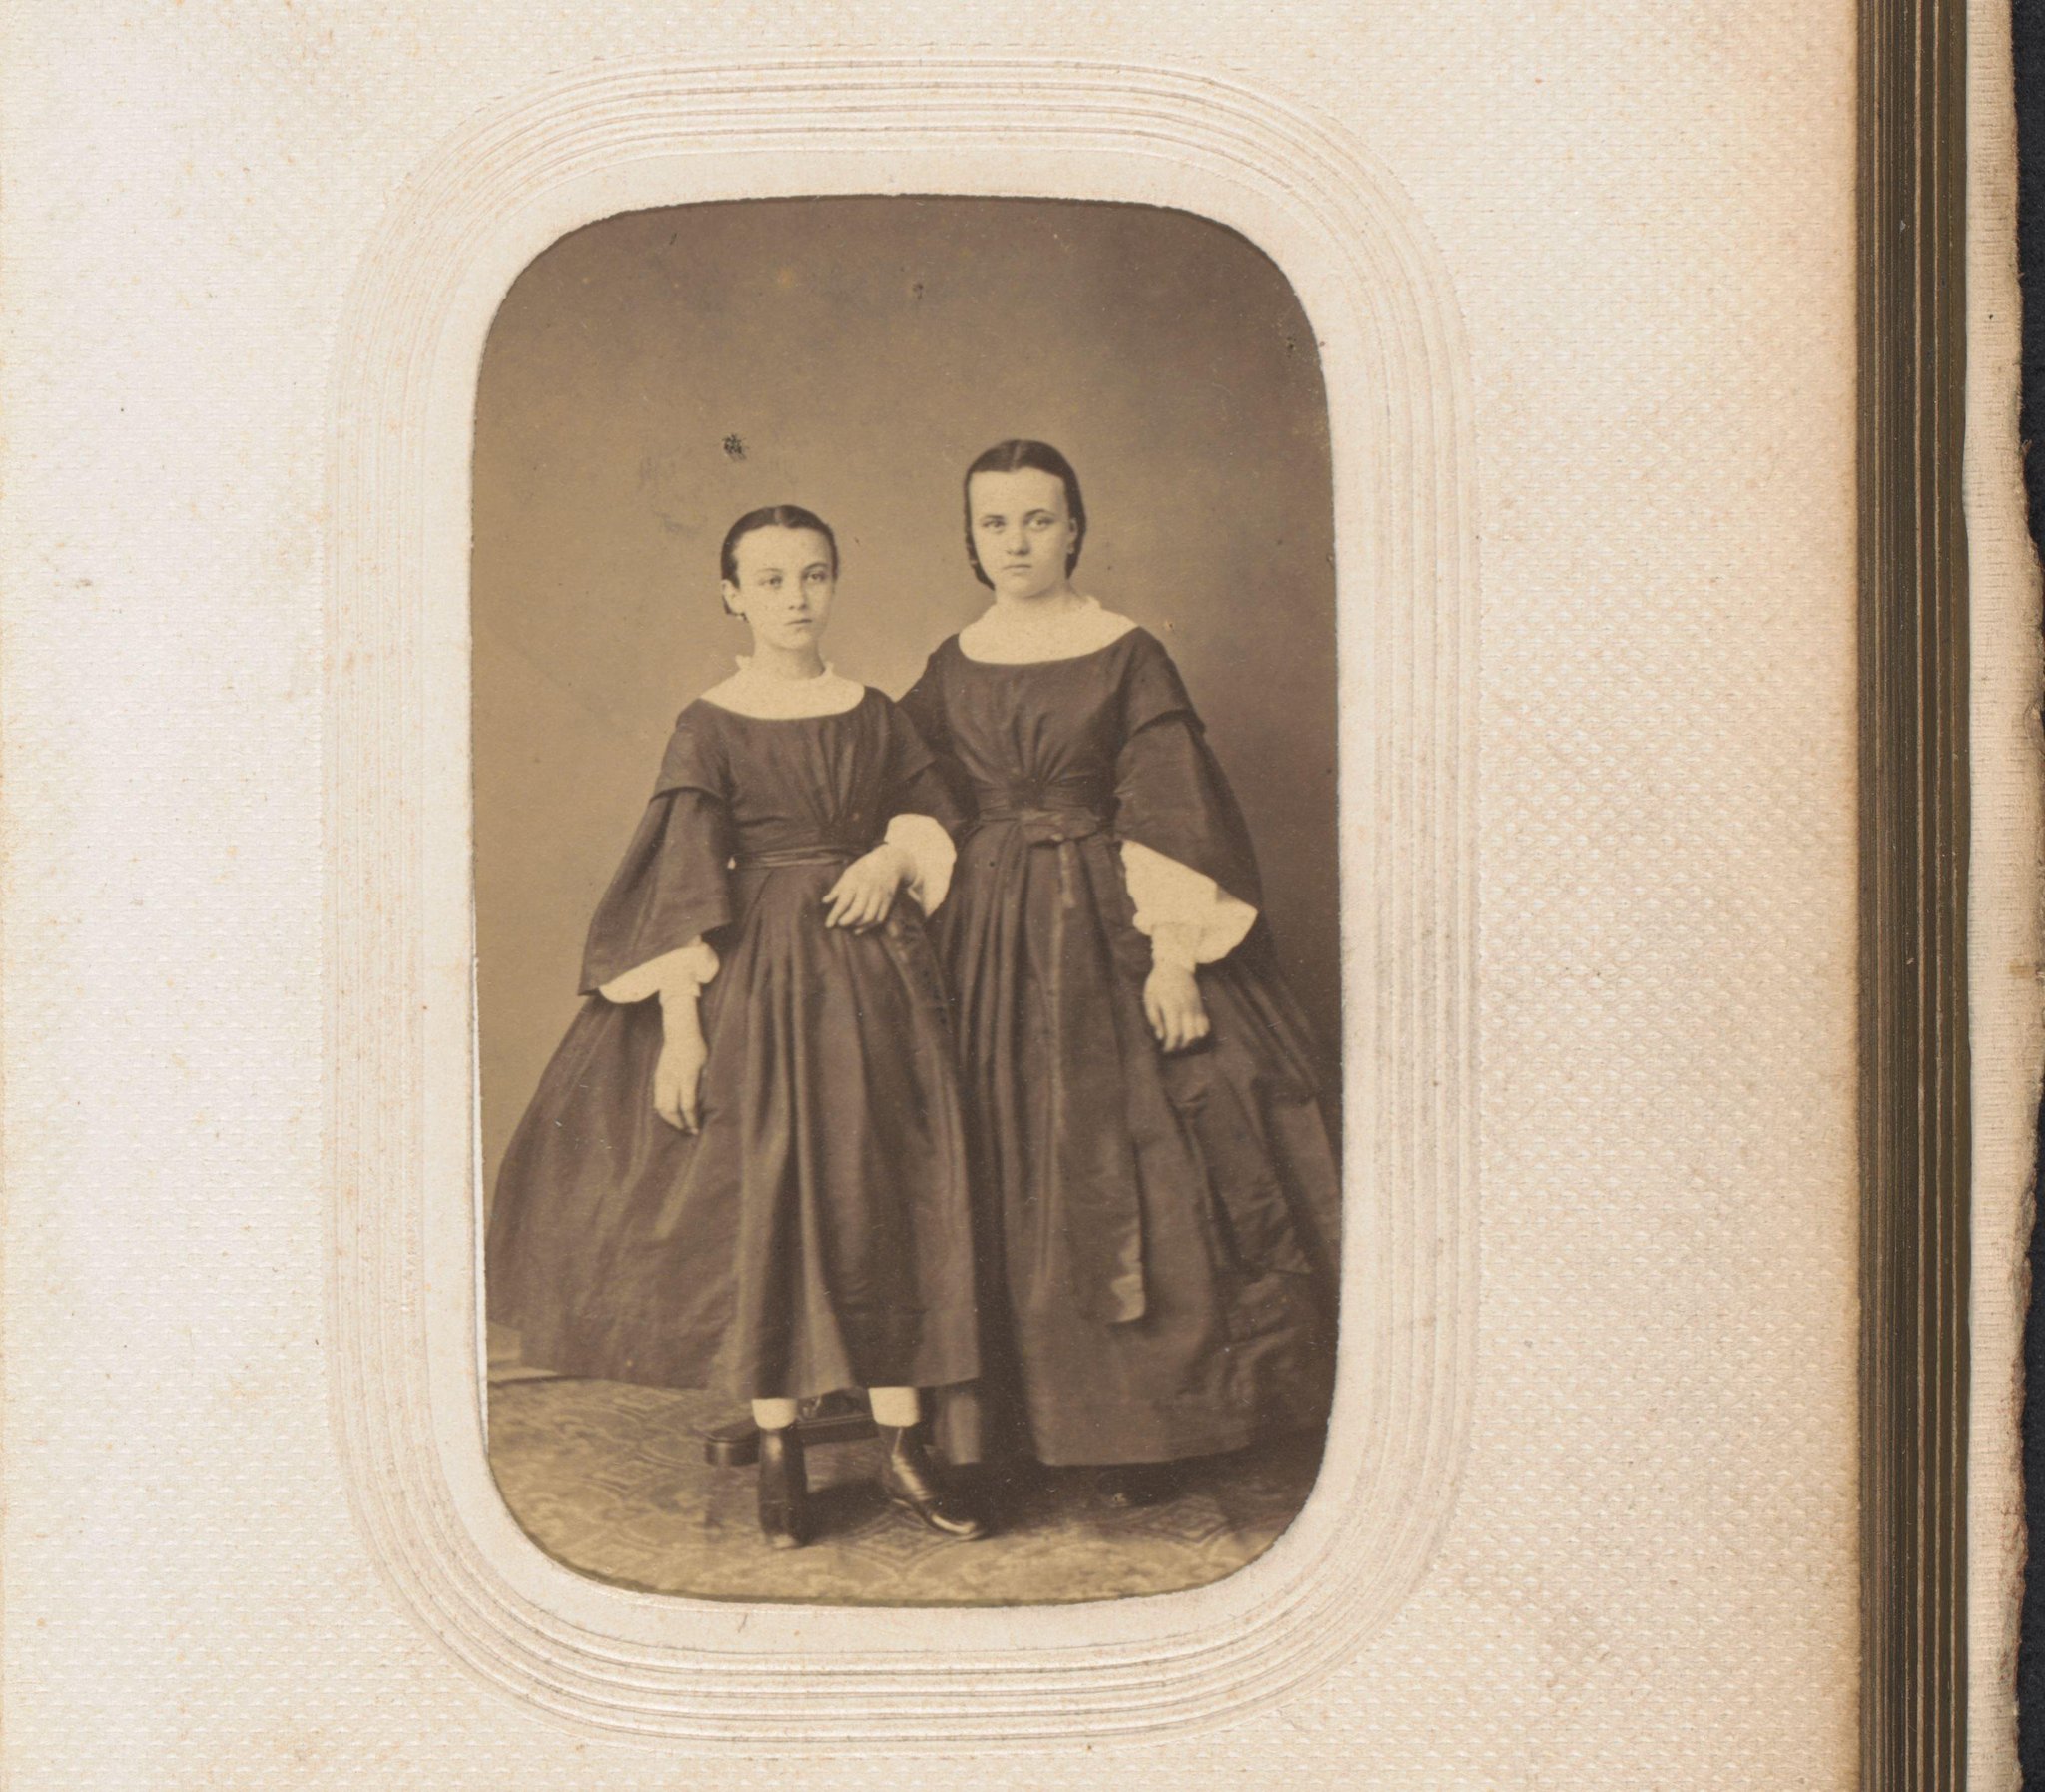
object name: photograph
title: Portret van een twee staande meisjes in identieke jurk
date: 1855-1865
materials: cardboard, photographic support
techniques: albumen print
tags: historical persons, dress, gown, child between toddler and youth (of undetermined sex)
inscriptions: inscription: ‘3 Rue Mautrec, Bordeaux’